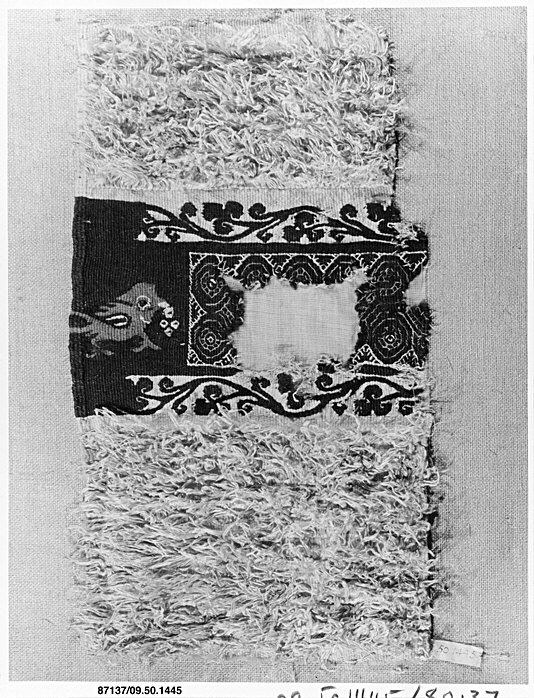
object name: textile fragment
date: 201-400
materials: linen, wool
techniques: embroidery, weave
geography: egypt